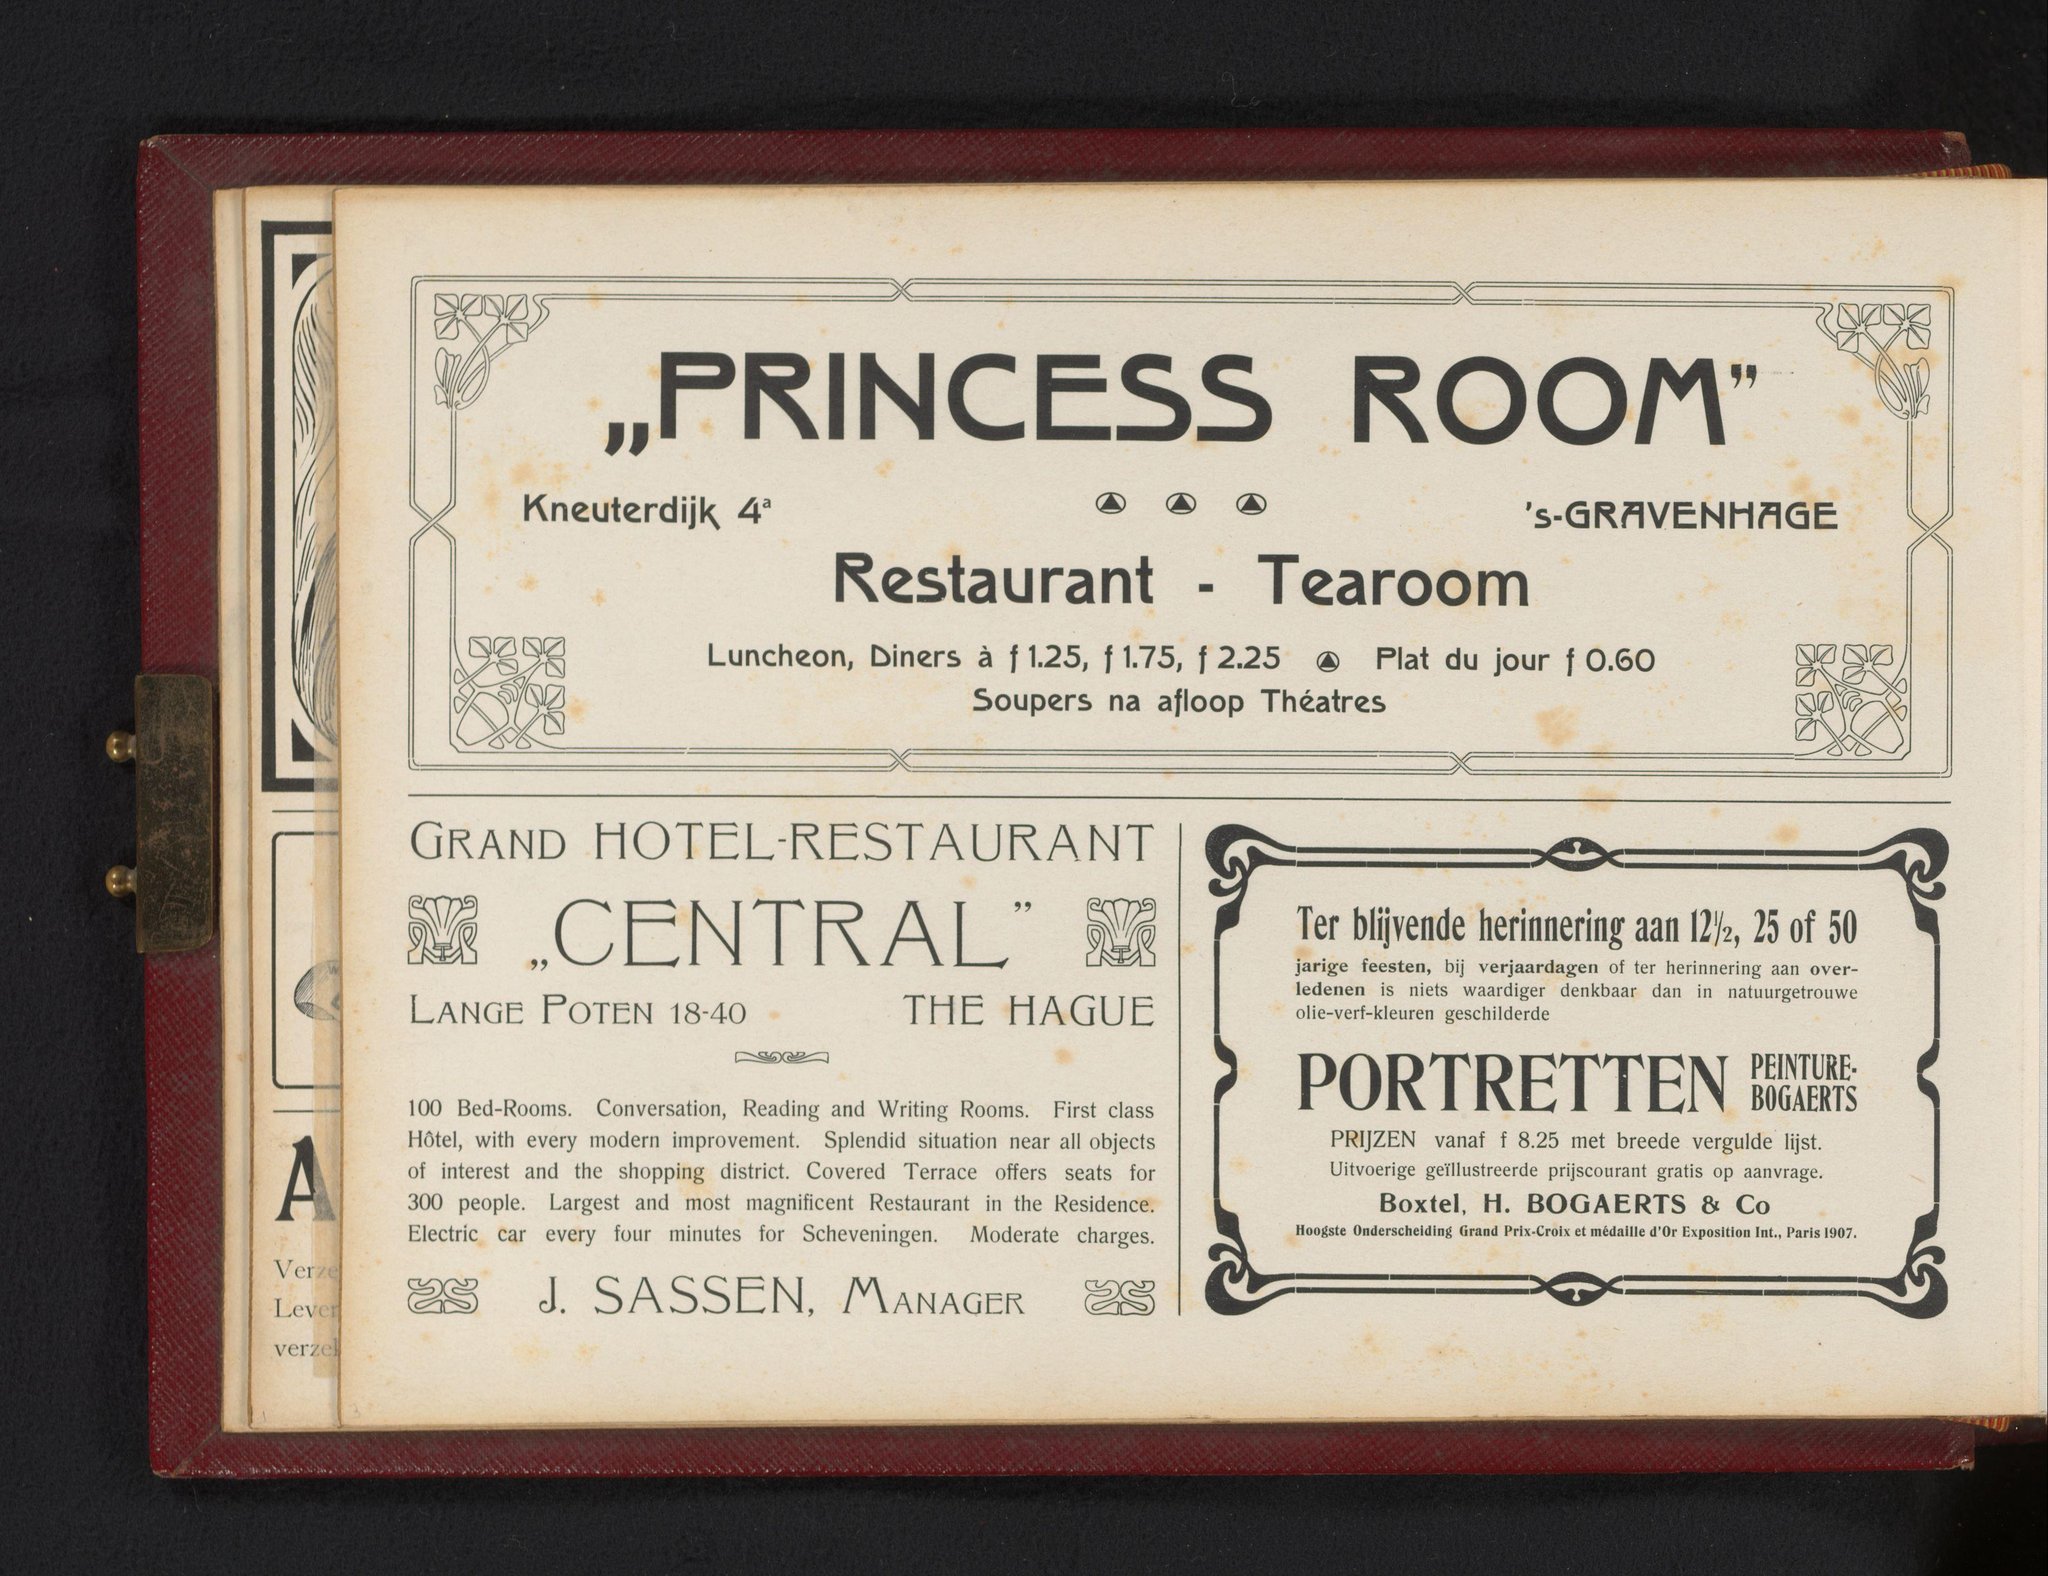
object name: album leaf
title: Advertenties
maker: Anonymous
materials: paper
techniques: printing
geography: netherlands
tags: advertising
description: Advertenties voor onder andere "Princess Room", Grand Hotel-Restaurant "Central" en H. Bogaerts & Co. Deze pagina maakt deel uit van een album.